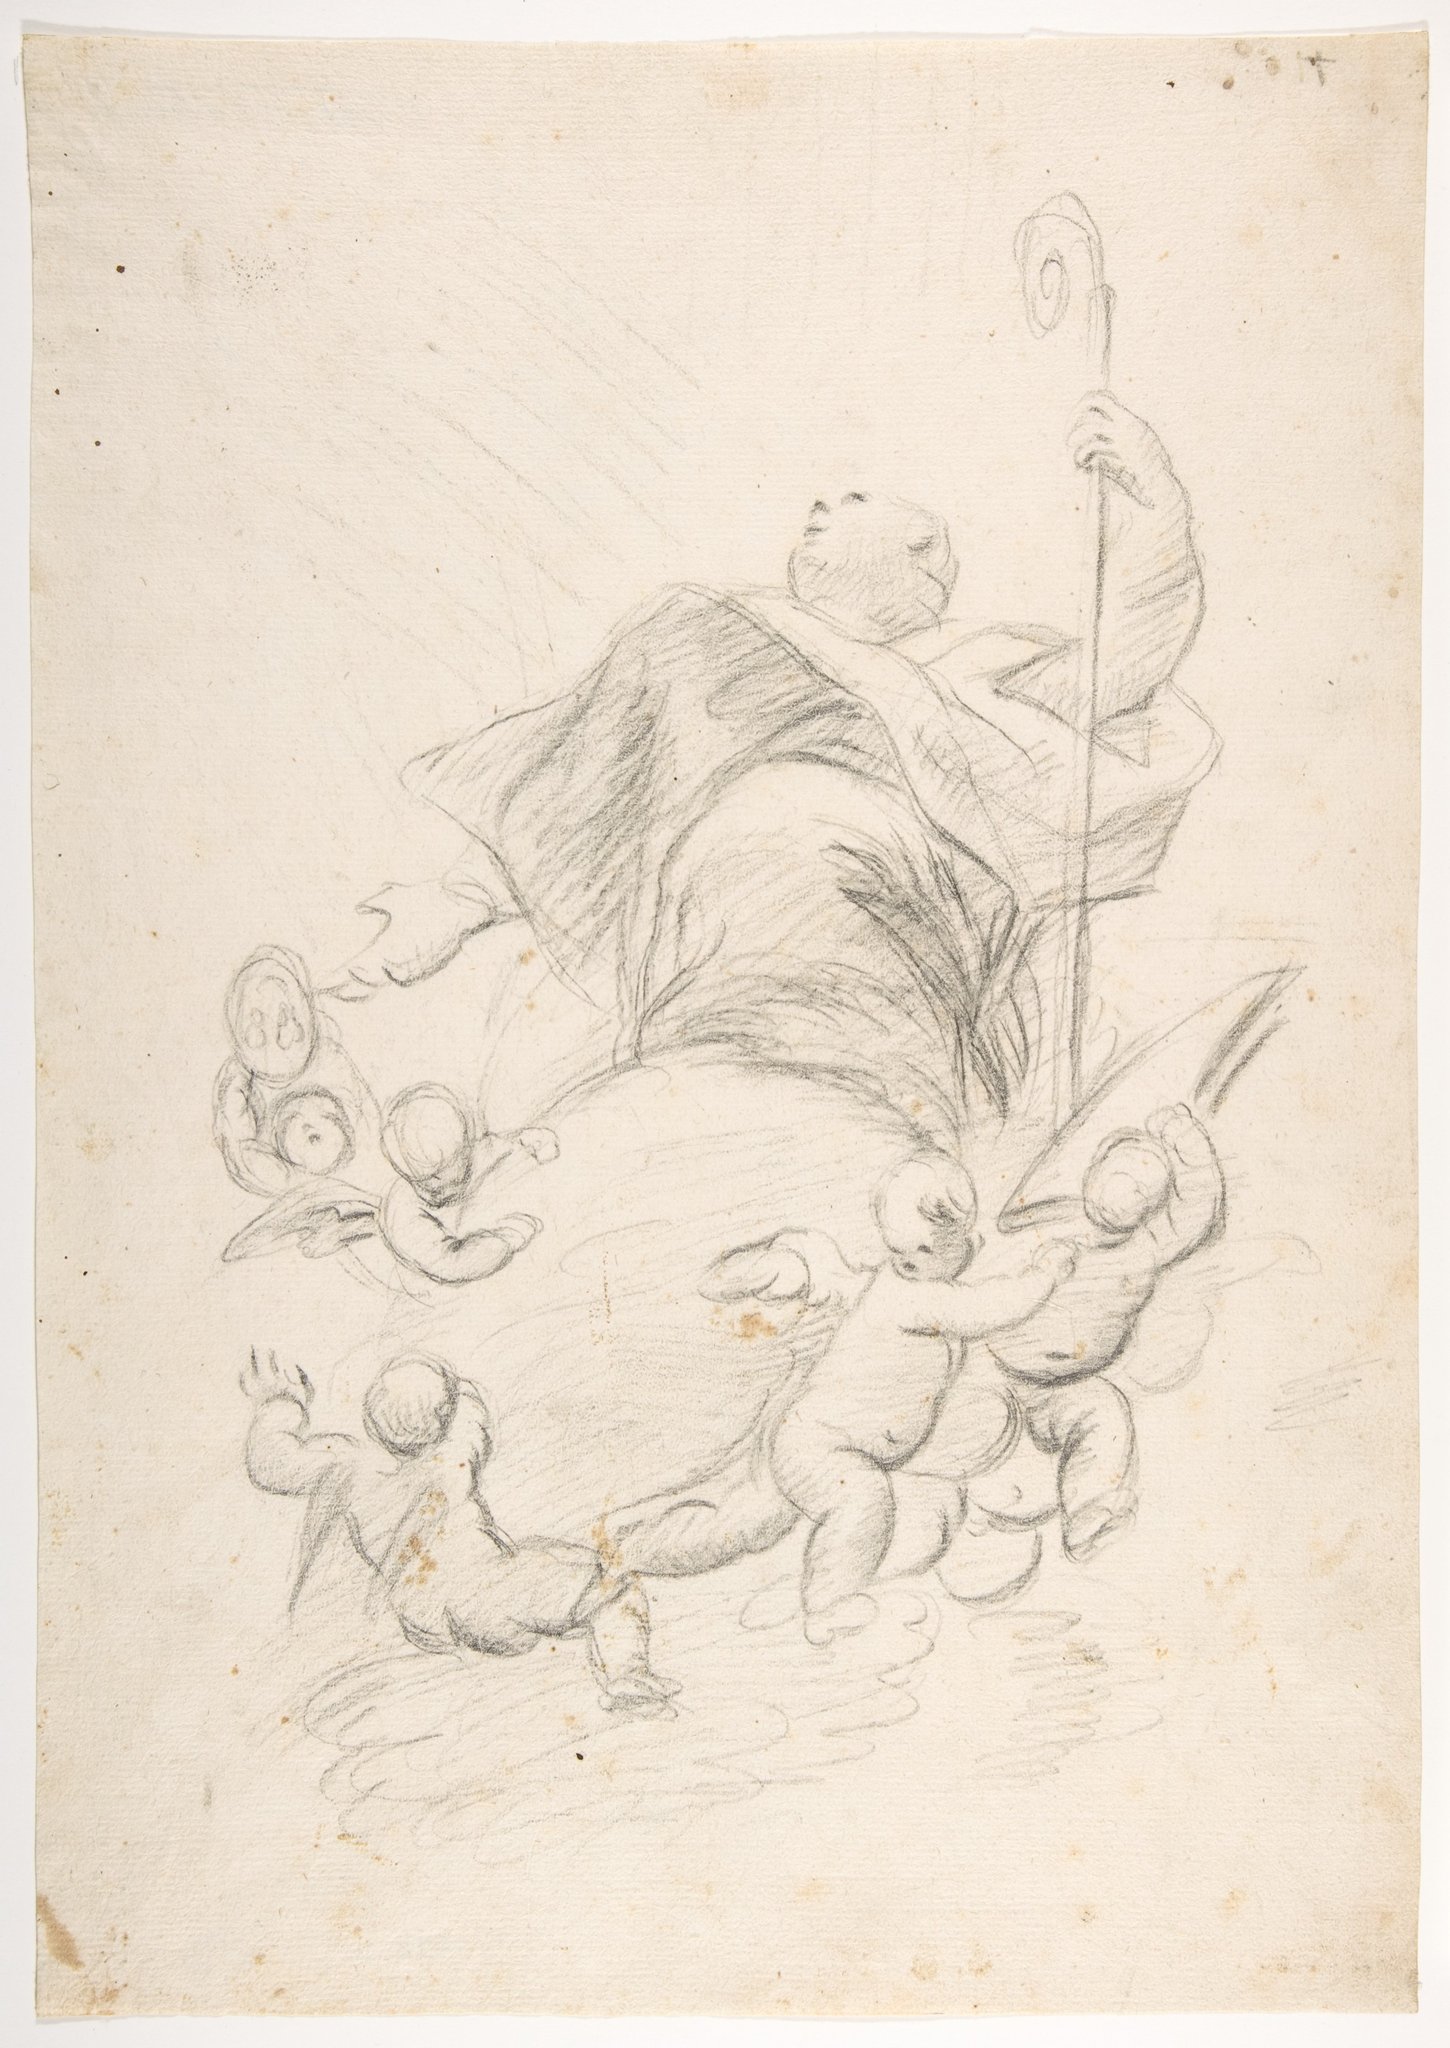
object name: drawing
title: Ascension of a Bishop Saint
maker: luca giordano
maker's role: artist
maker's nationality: italian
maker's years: 1634-1705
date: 1634-1705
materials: chalk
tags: angels,bishops,croziers,saints